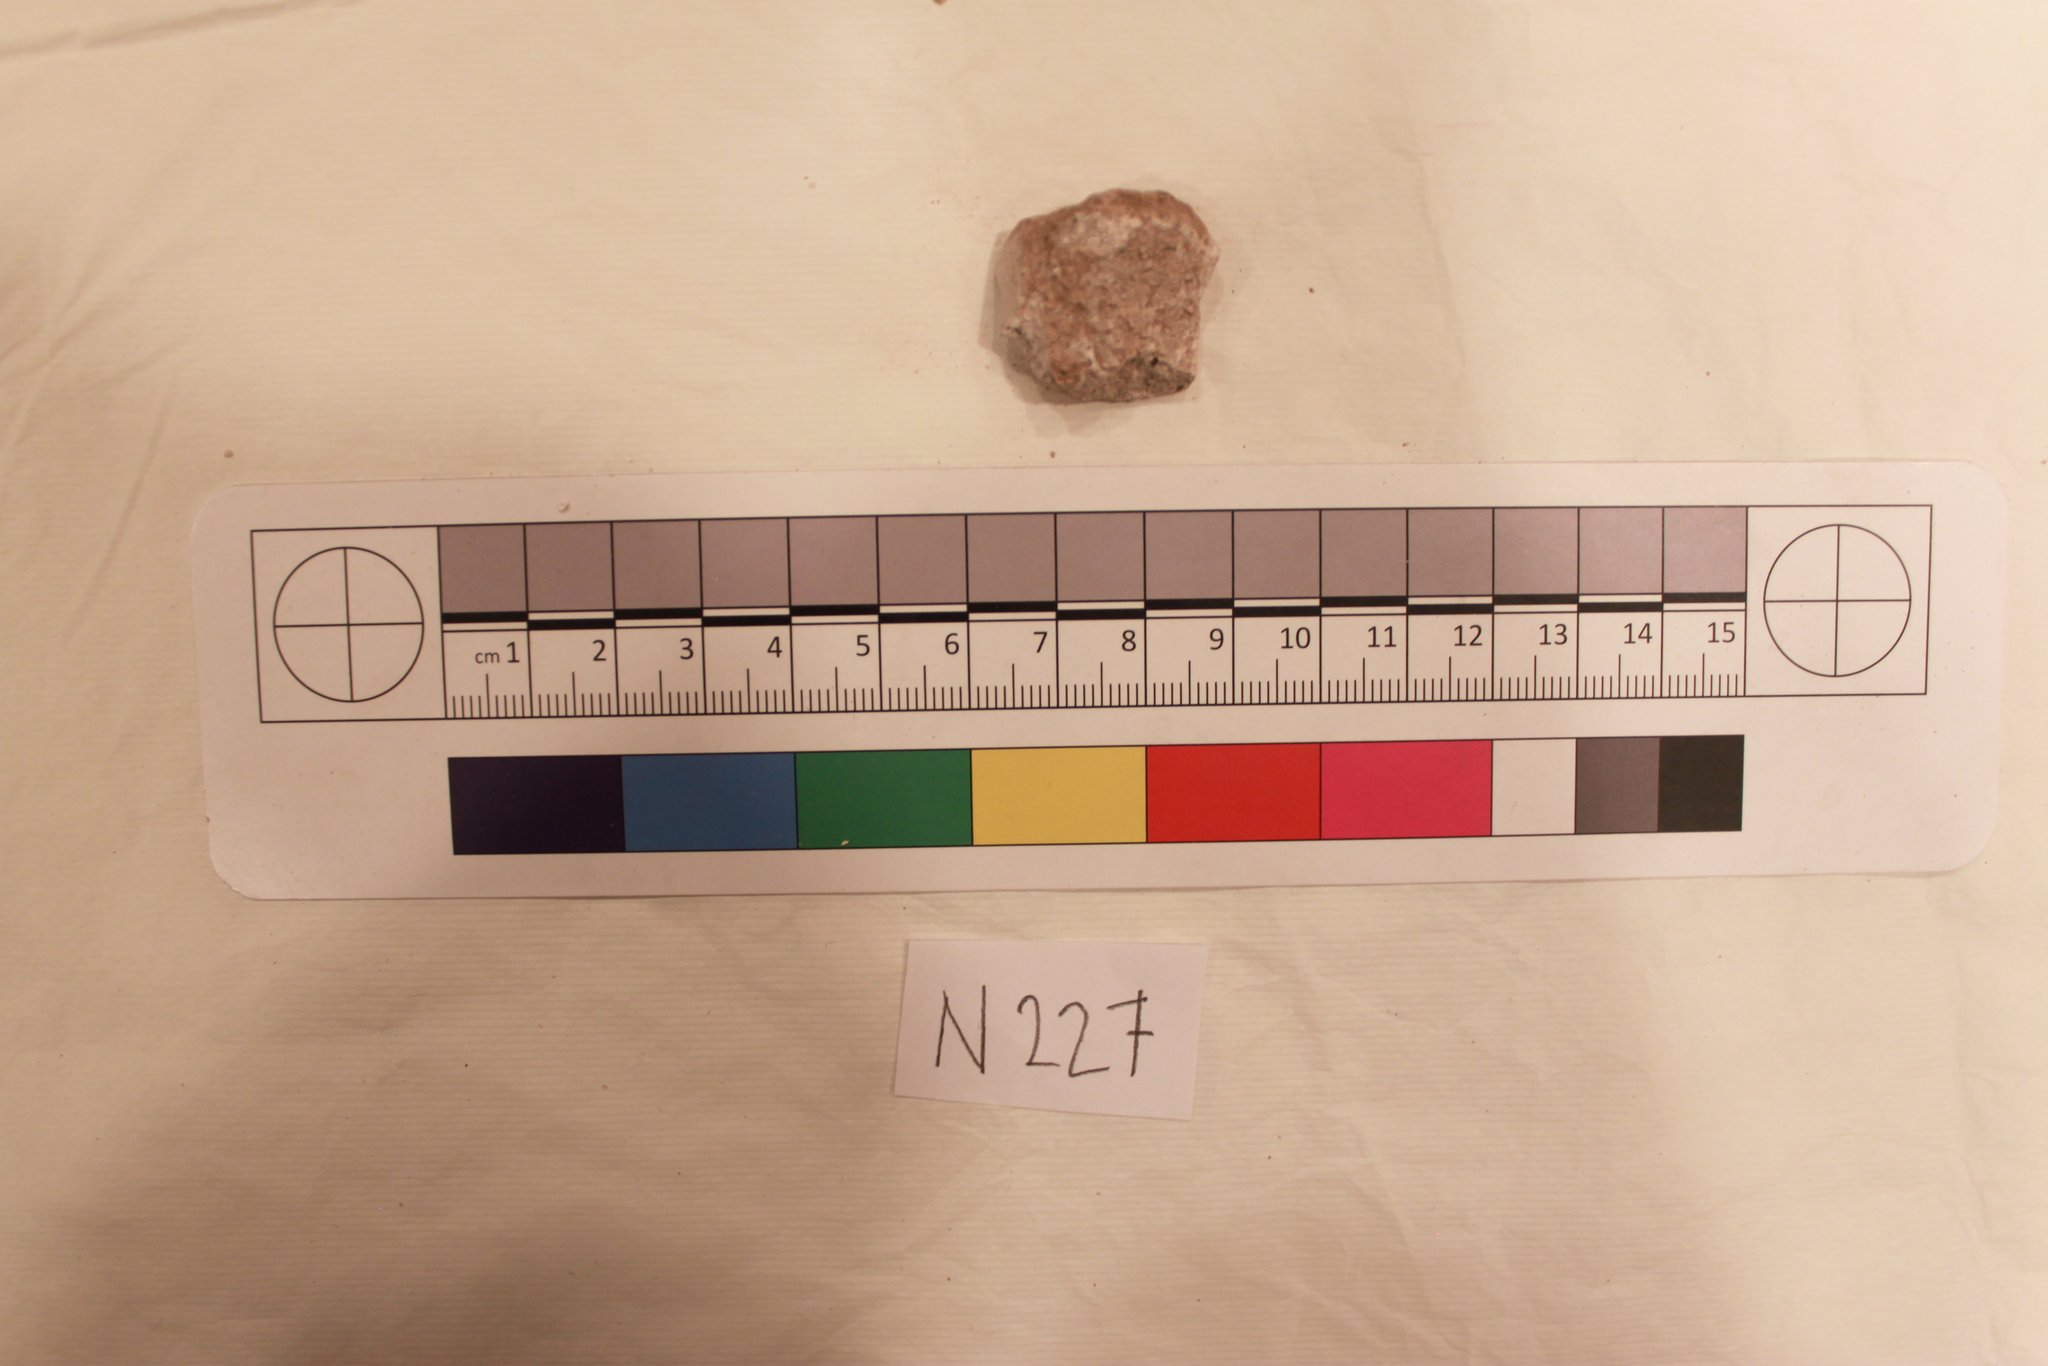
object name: fragment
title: Stucco Fragment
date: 701-1200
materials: plaster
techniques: carving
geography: iran